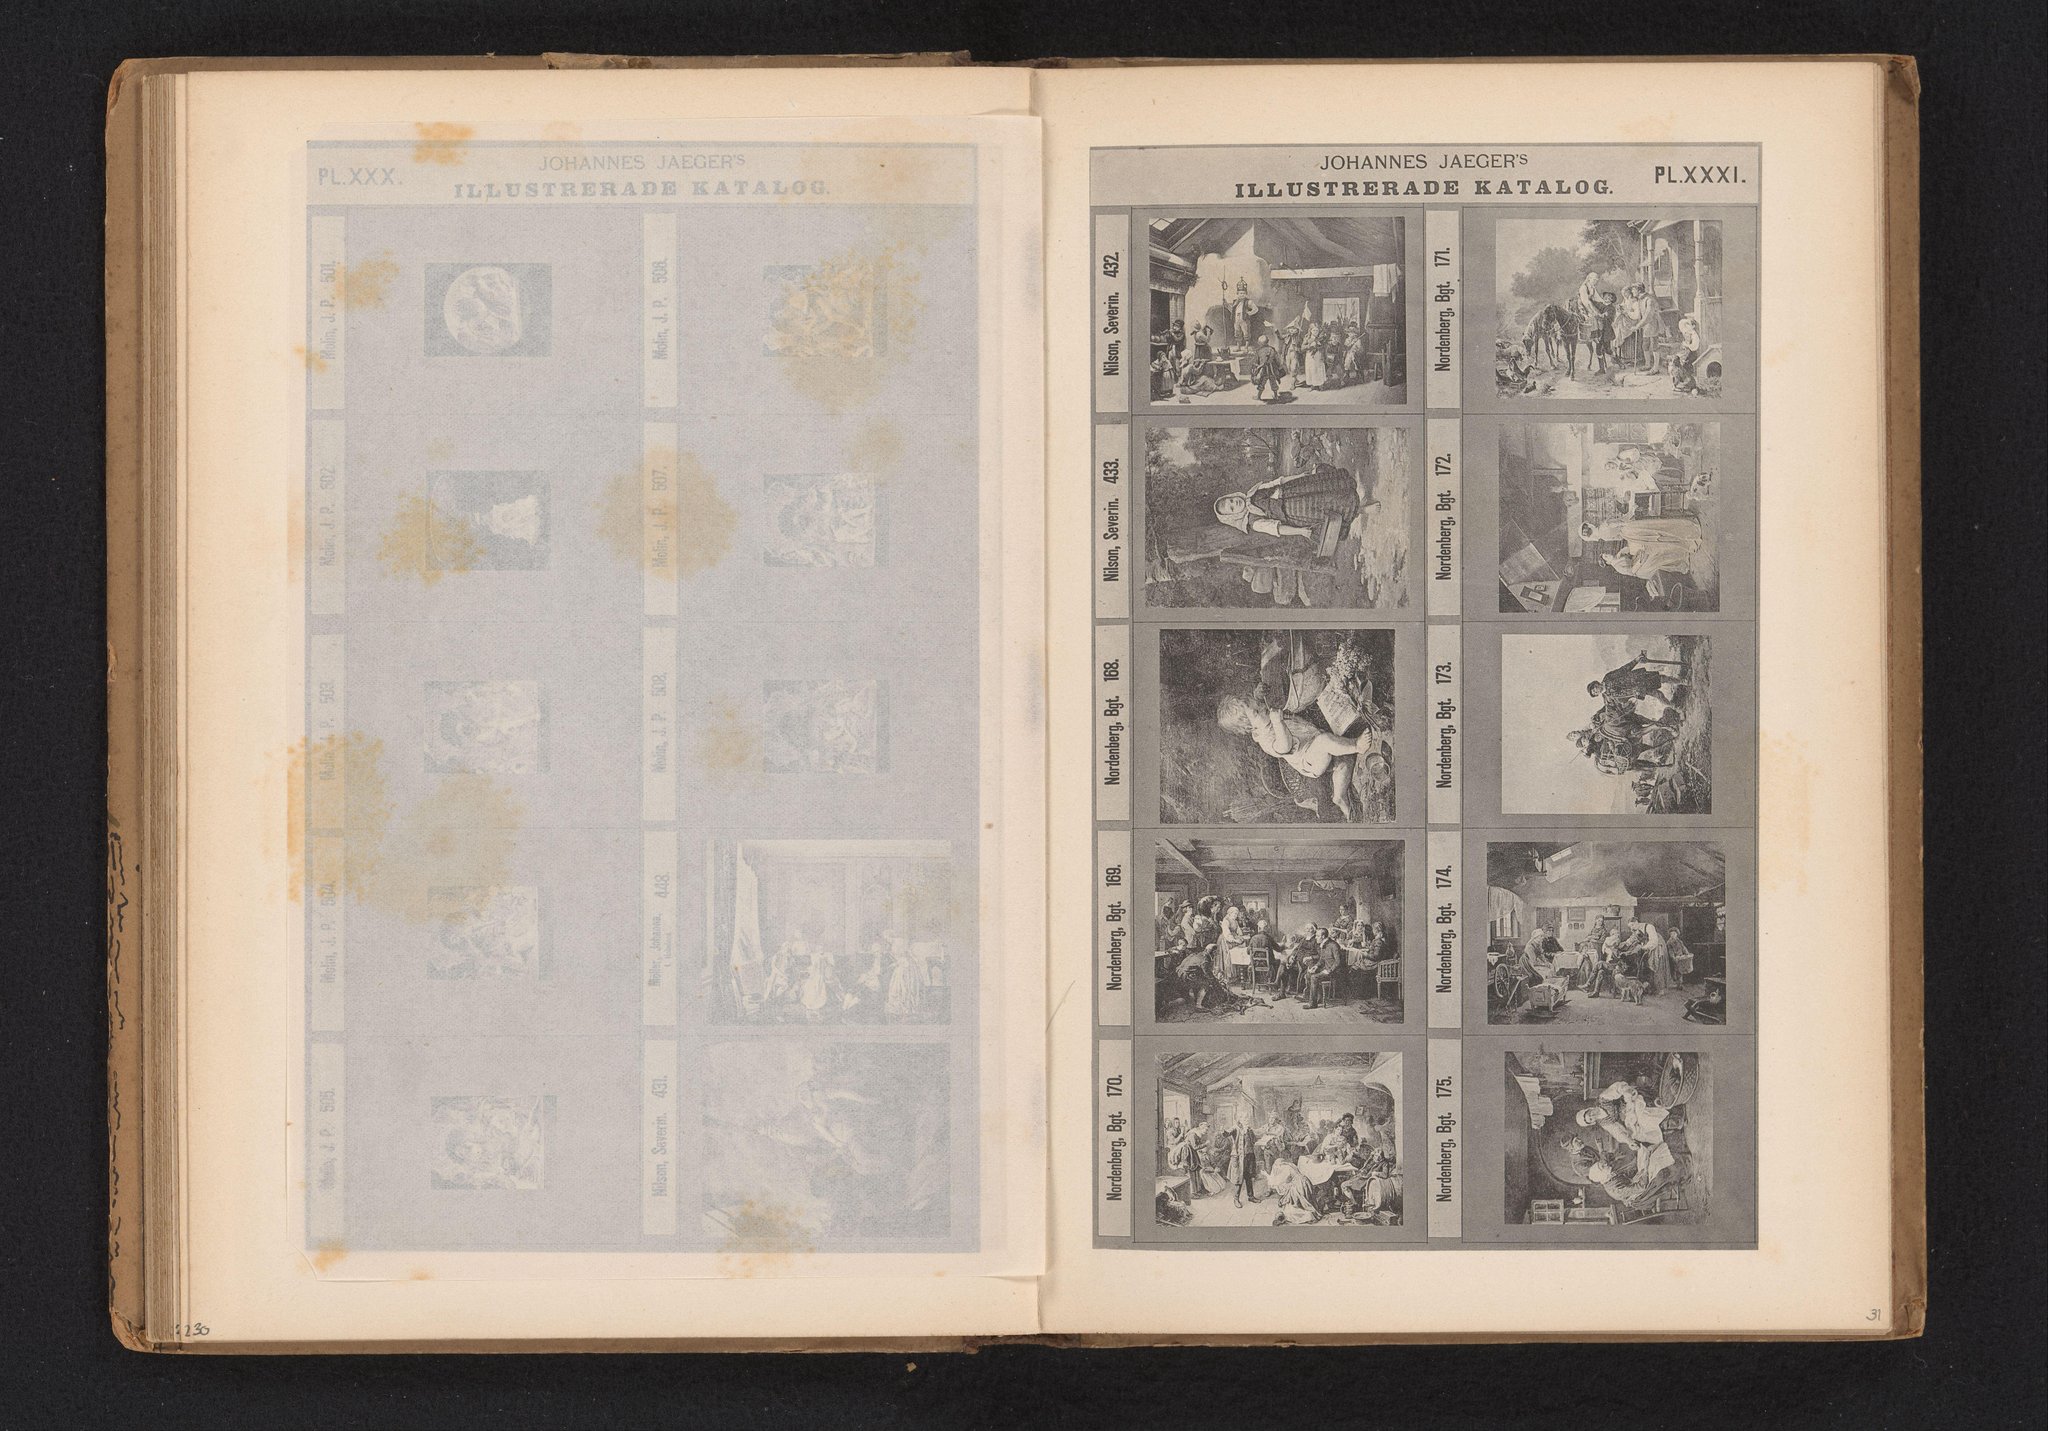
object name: page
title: Fotoreproductie van tien genretaferelen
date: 1872-1882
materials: paper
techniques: photograph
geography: stockholm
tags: picture, painting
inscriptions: number: ‘PL. XXXI.’